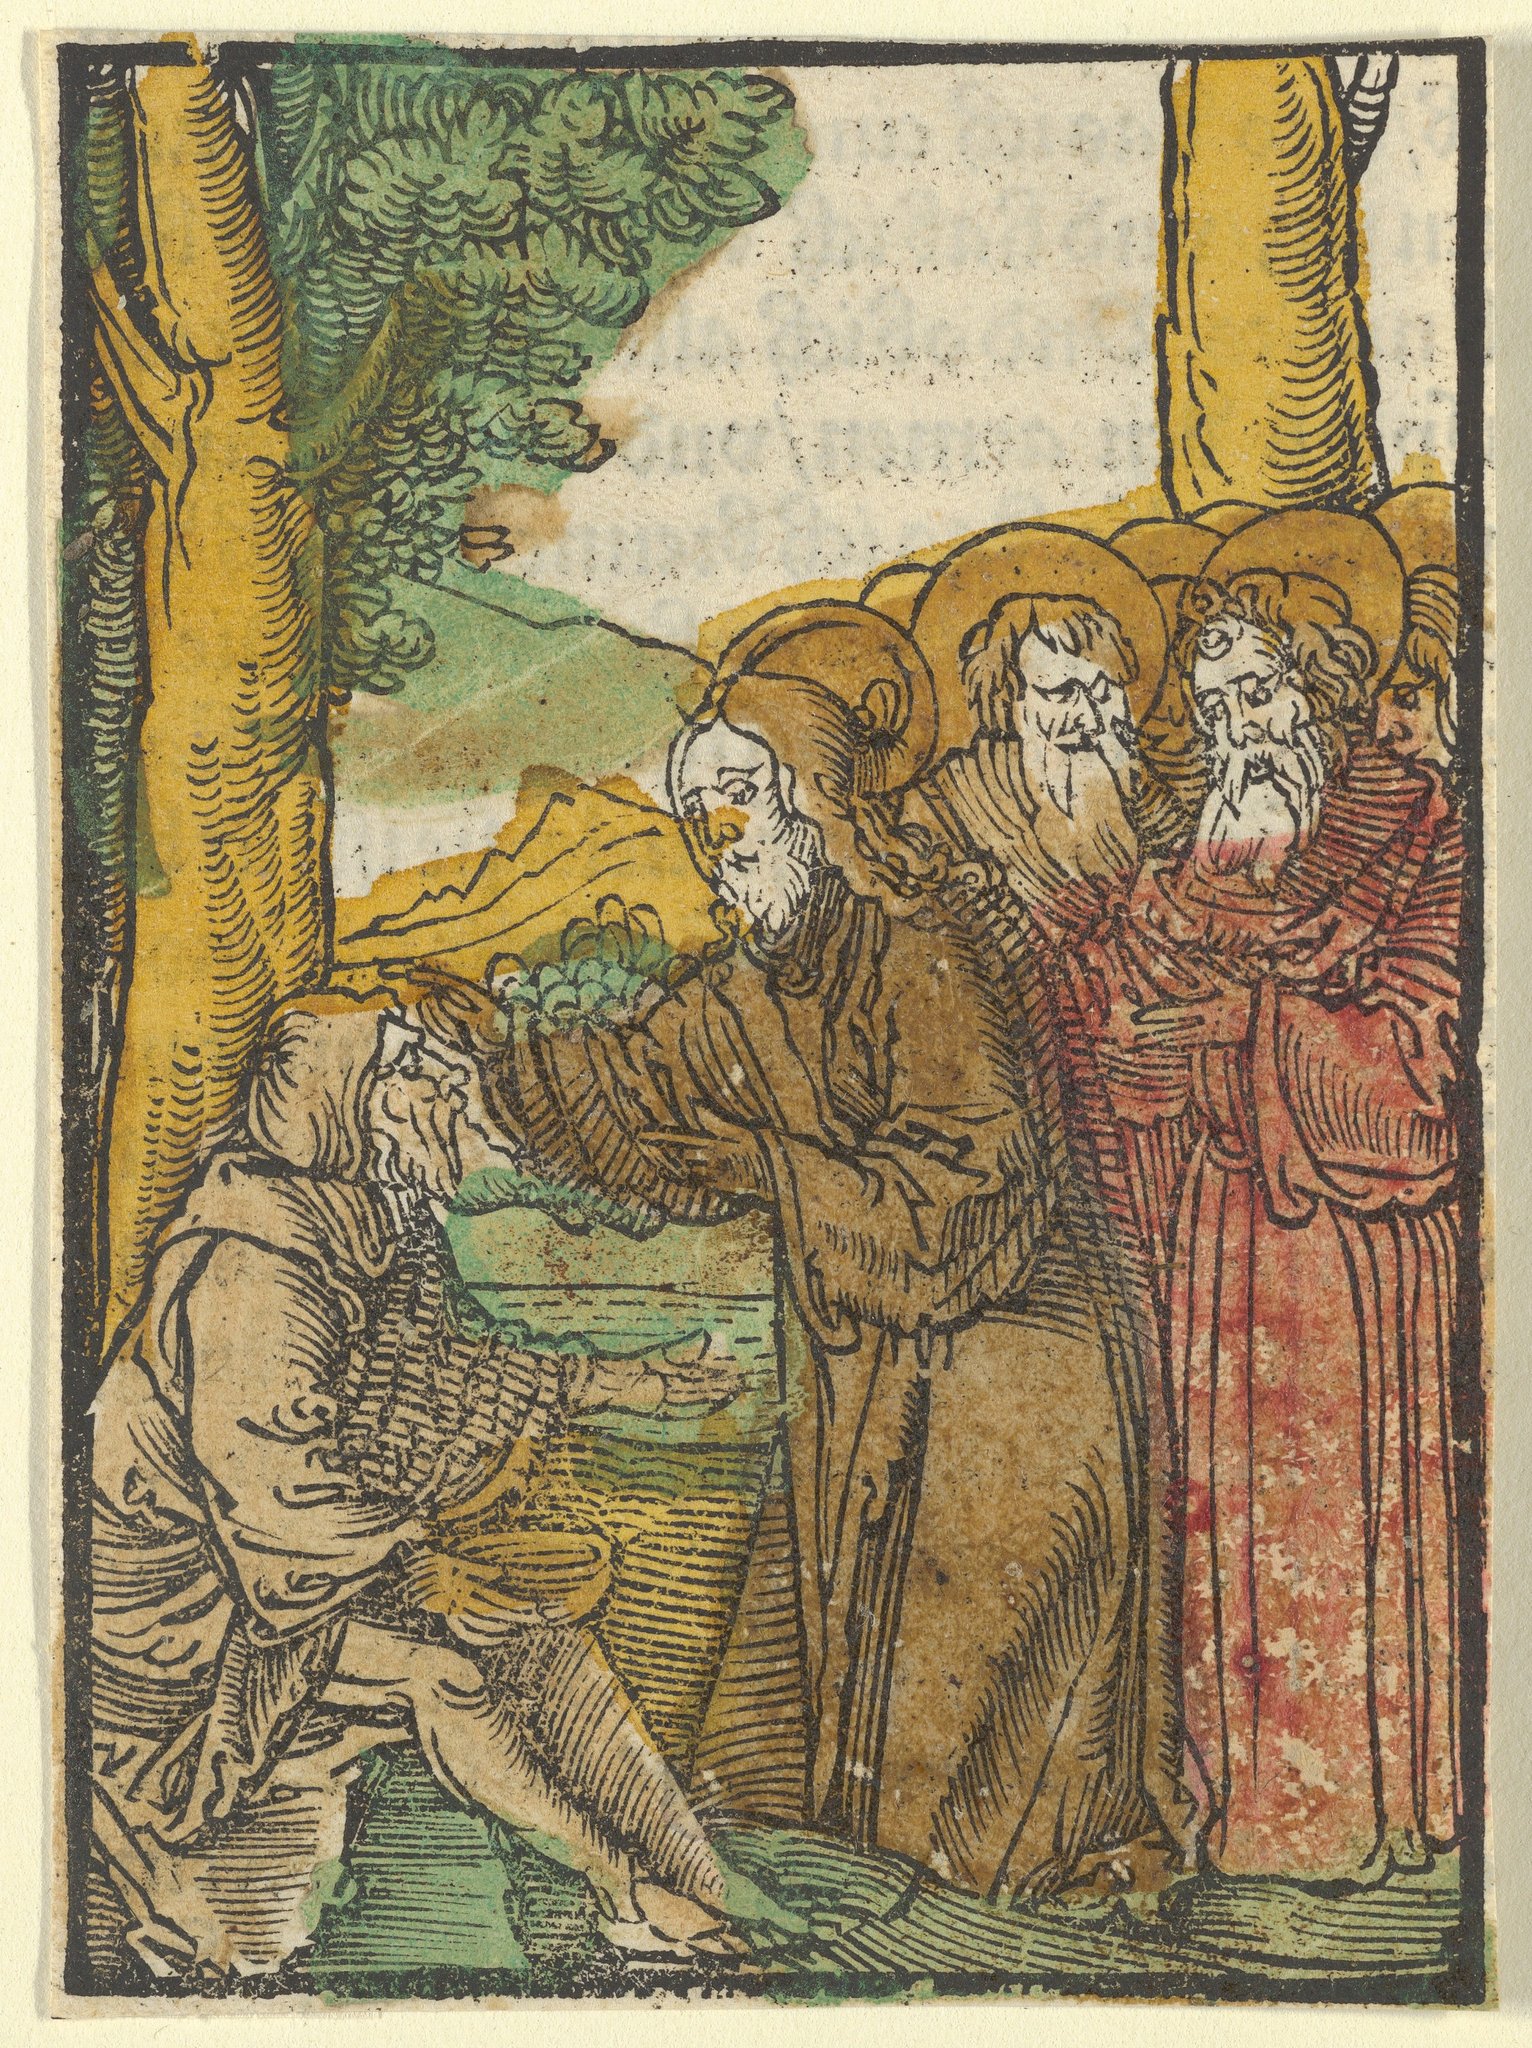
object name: print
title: Christ Healing the Blind, from Das Plenarium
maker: hans schäufelein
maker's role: artist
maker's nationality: german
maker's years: 1480-1540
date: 1517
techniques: hand coloring, woodcut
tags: men,christ